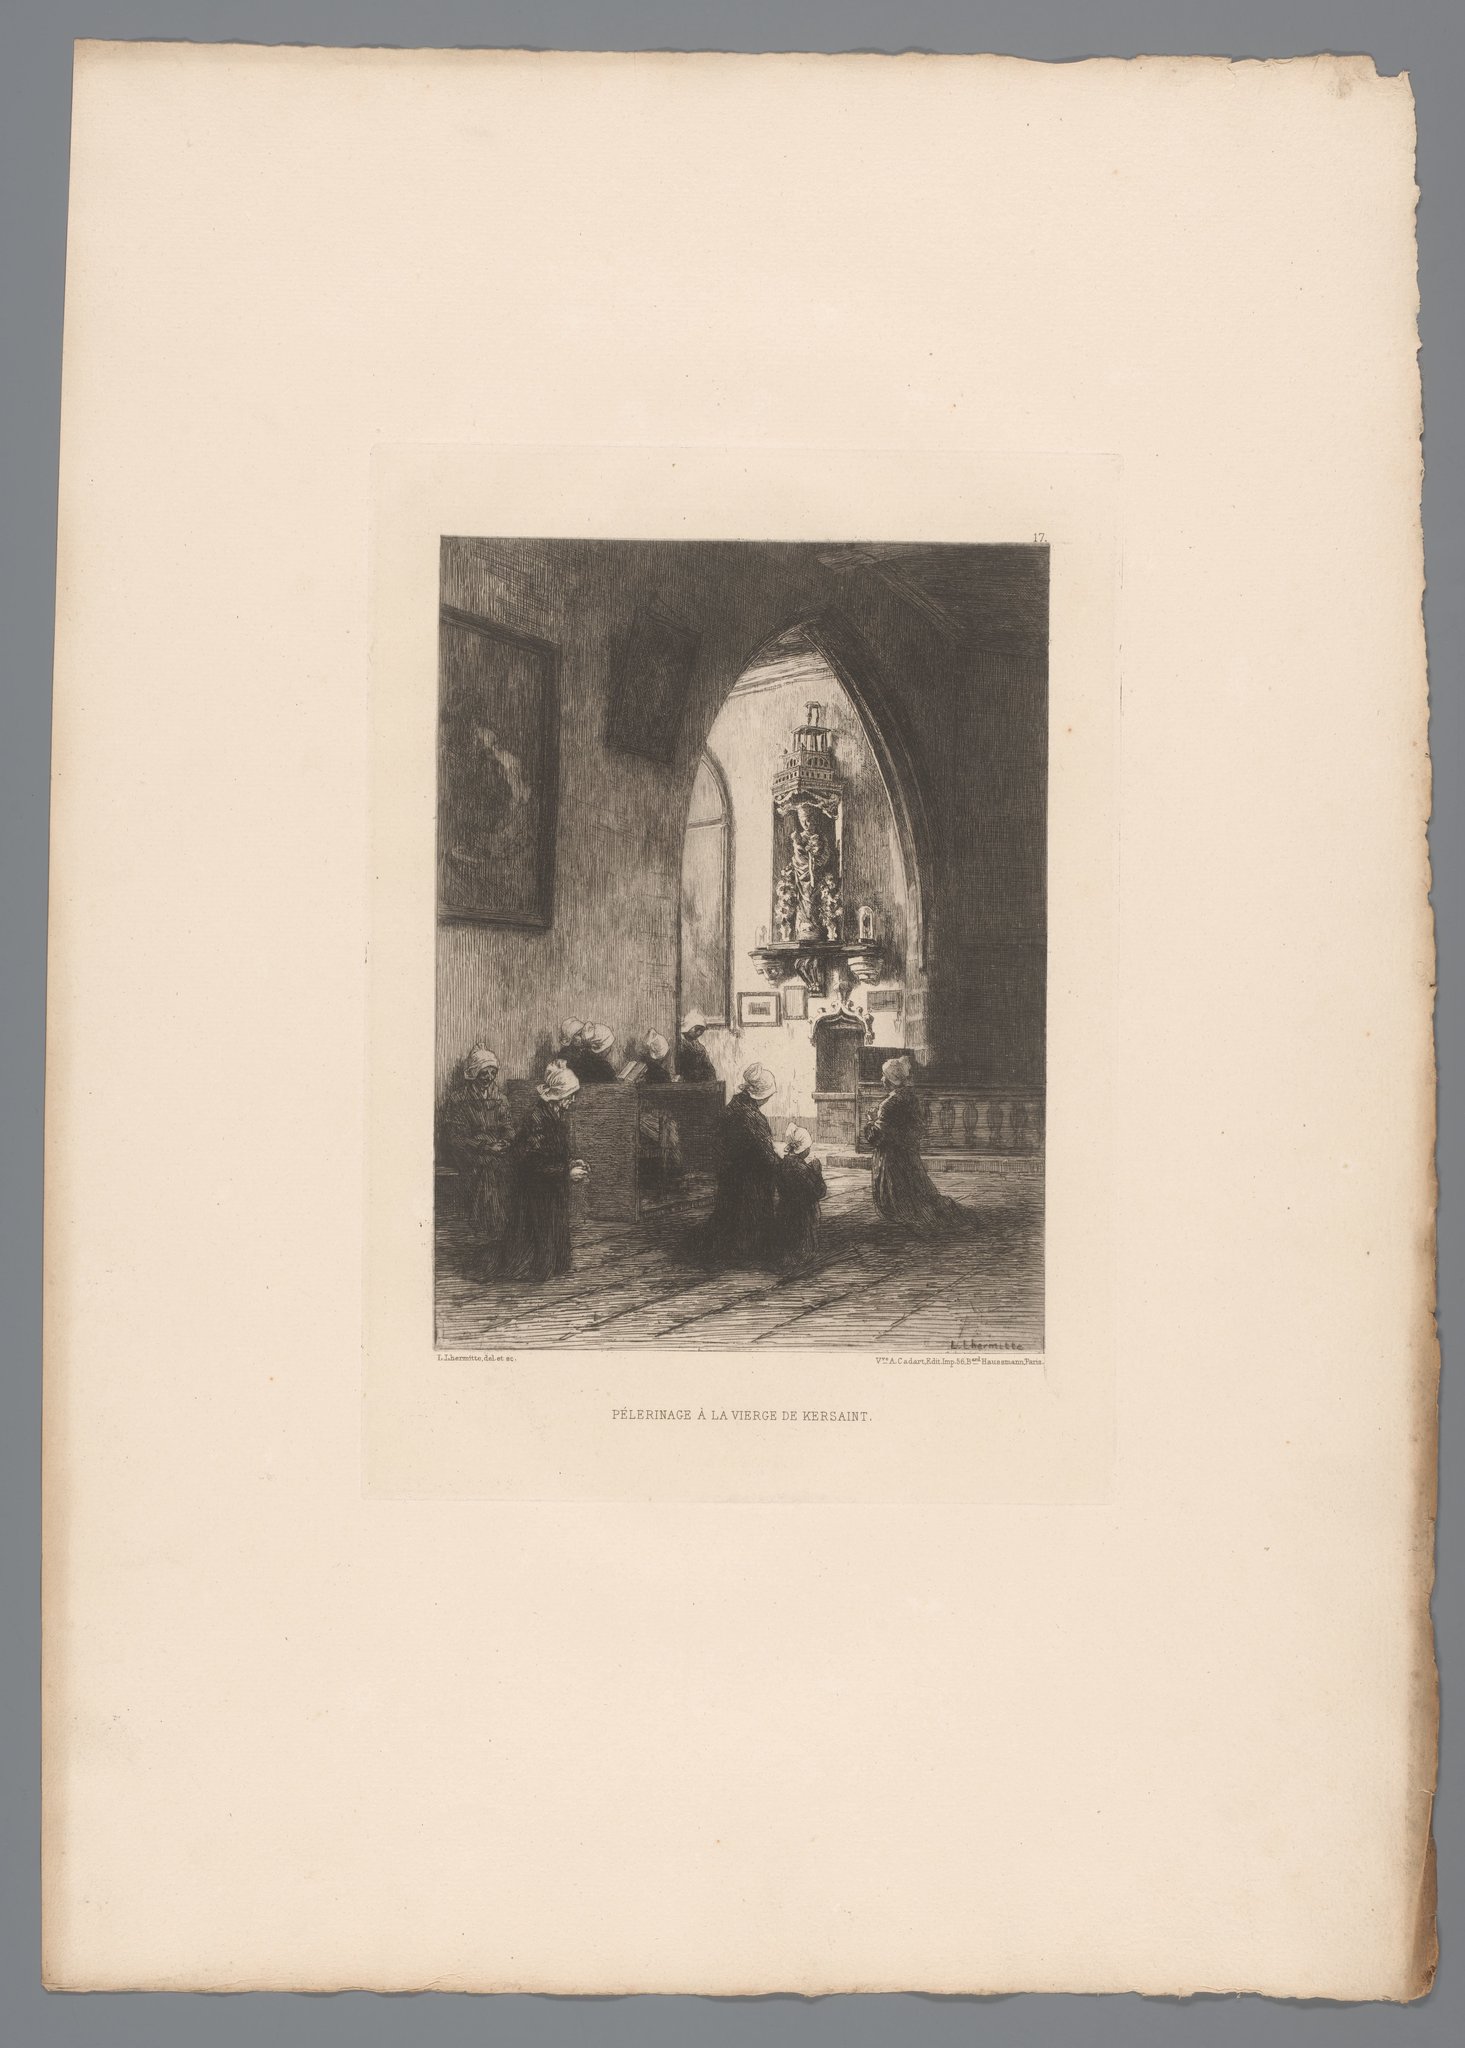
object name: print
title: L'eau-forte en 1878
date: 1878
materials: paper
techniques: drypoint, etching, intaglio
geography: paris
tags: interior of church, pilgrimage, pilgrim(s) under way, female saints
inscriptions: collector's mark: Lugt 2760, collector's mark: ‘AFE v S’, collector's mark: Lugt 2228, watermark